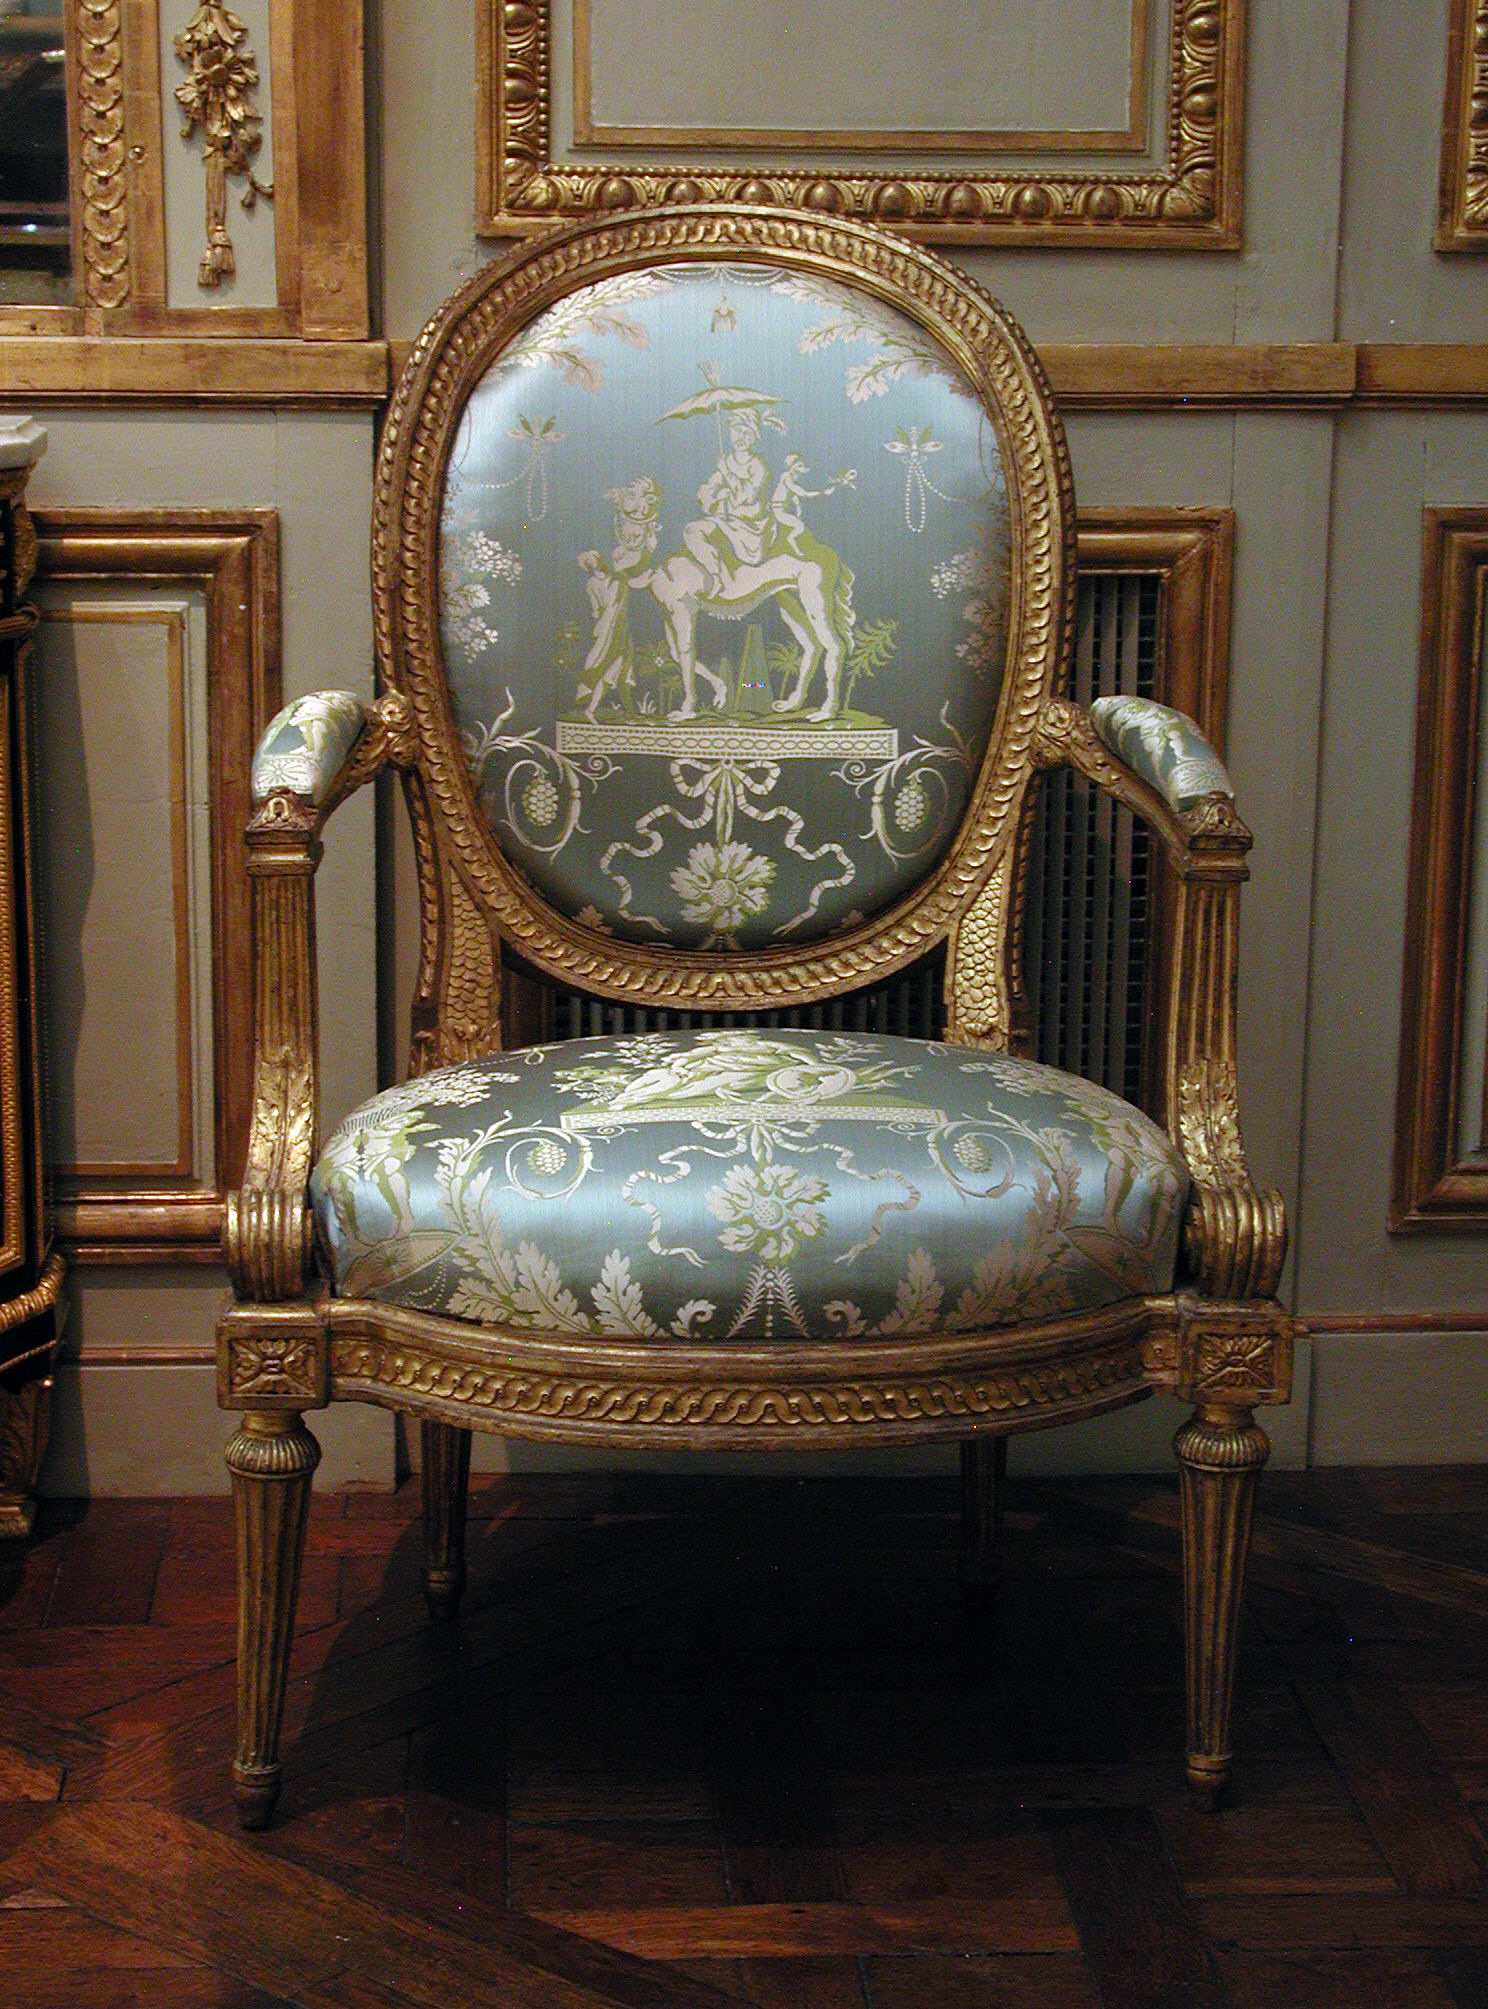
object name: armchair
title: Armchair (one of four) (part of a set)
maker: louis delanois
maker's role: maker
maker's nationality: french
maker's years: 1731-1792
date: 1770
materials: wood, silk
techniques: carving, damask, gilding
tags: human figures,camels